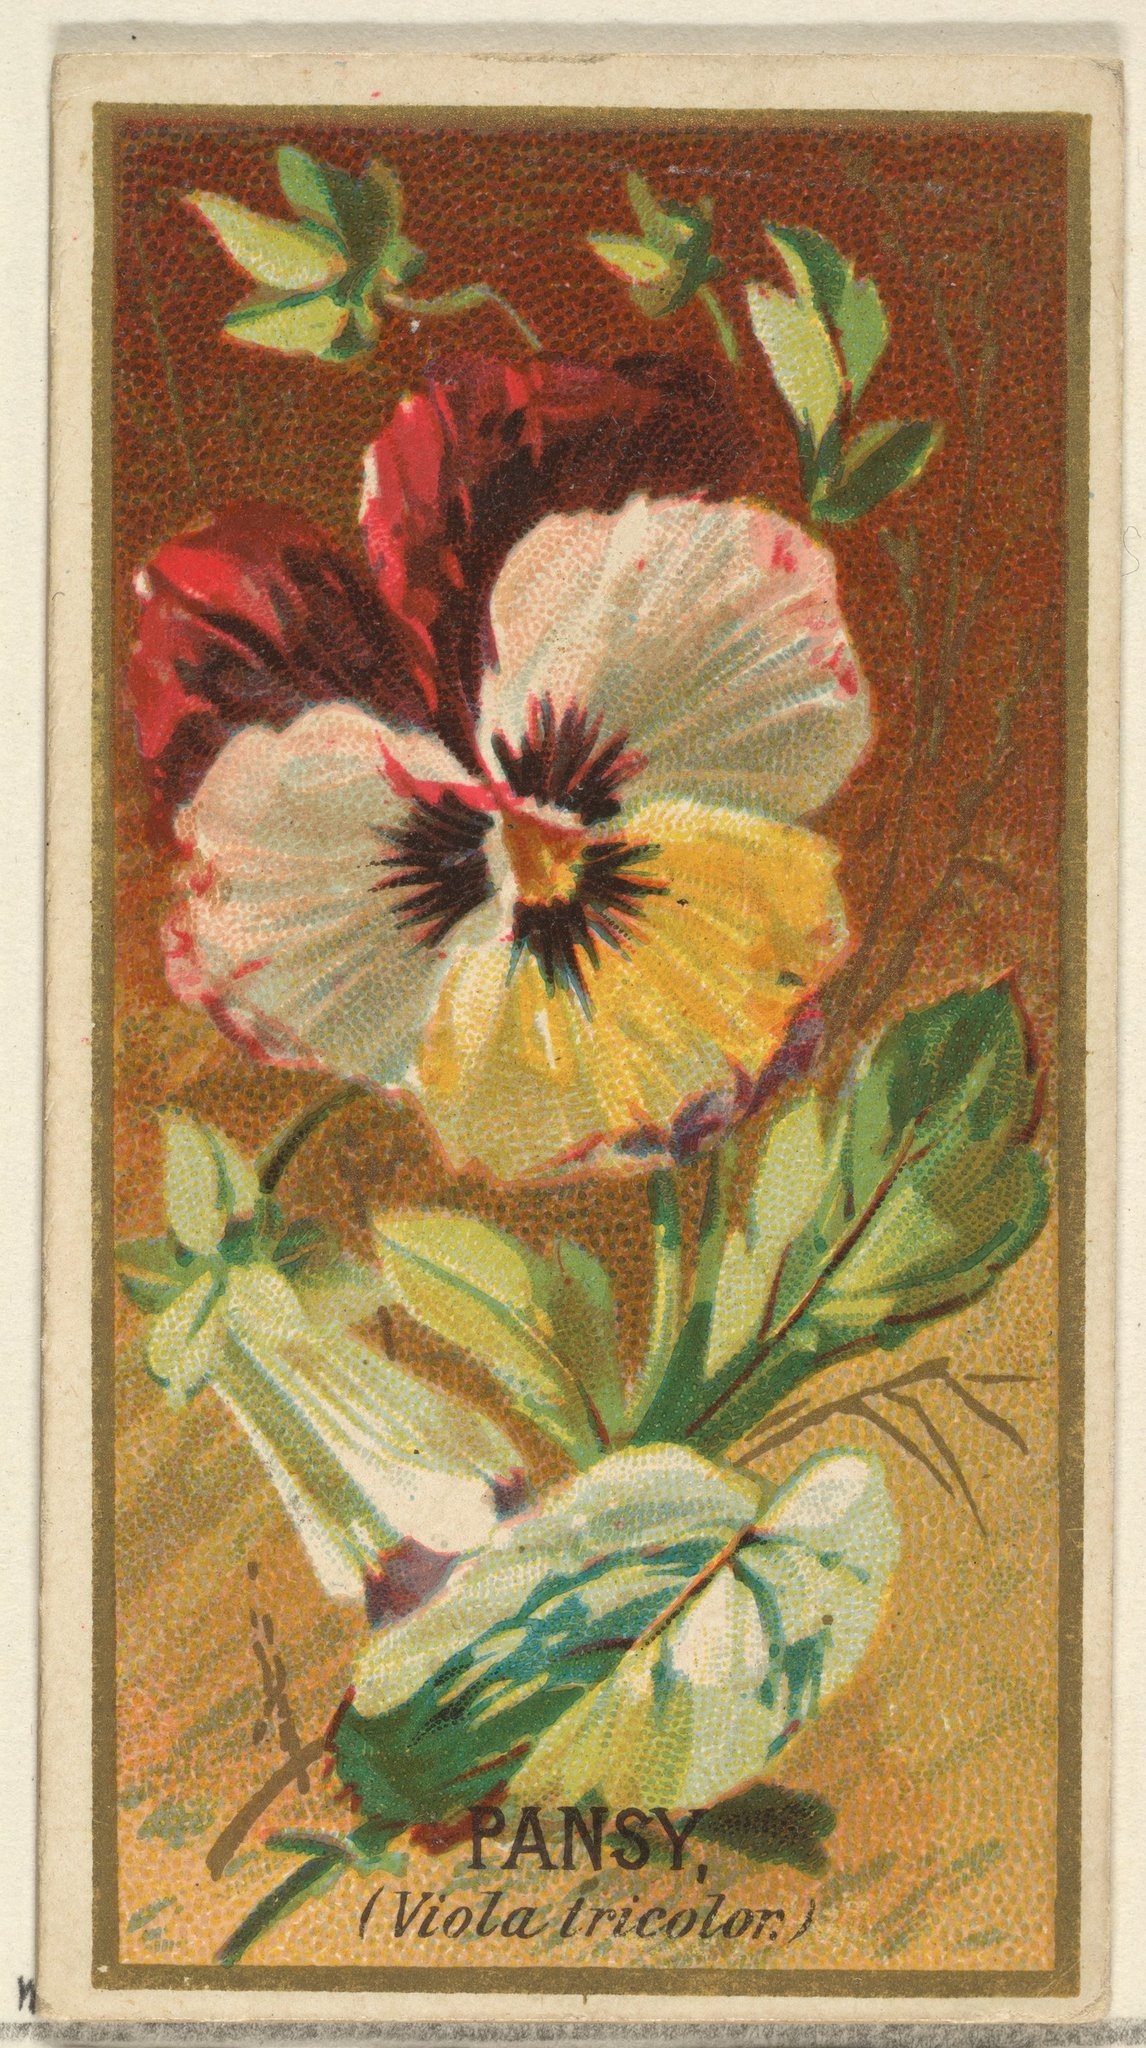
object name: print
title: Pansy (Viola tricolor), from the Flowers series for Old Judge Cigarettes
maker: goodwin & company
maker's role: publisher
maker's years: 1850-1950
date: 1890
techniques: color lithograph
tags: flowers,leaves